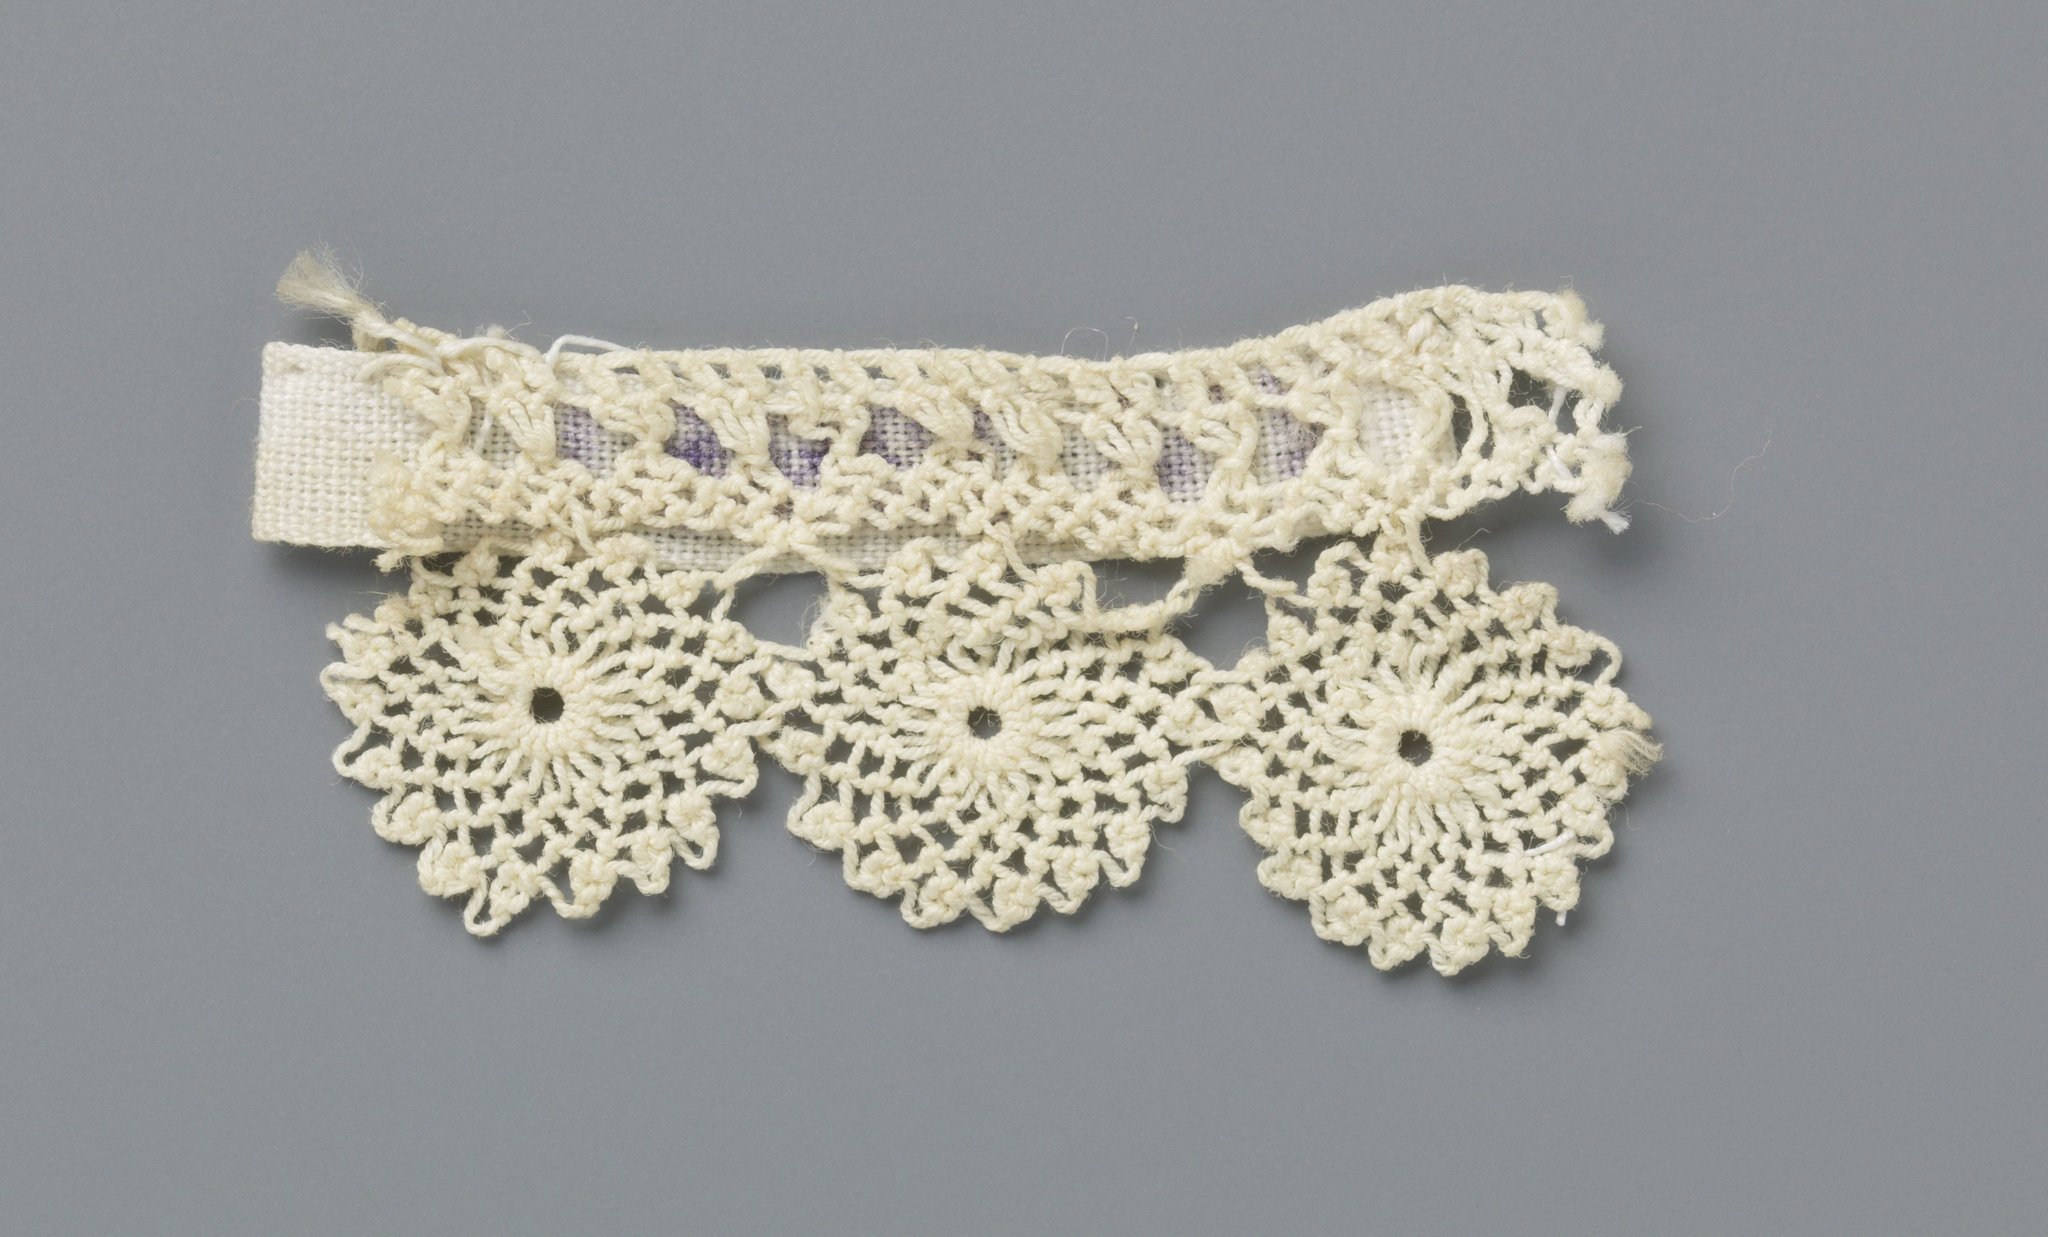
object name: strip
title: Strook geknoopte kant met drie cirkeltjes onder een smalle rechte baan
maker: Anonymous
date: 1900-1922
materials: linen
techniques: lace, knotted lace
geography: palestine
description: Strook naturelkleurige geknoopte kant: Chebka. Drie cirkeltjes onder een smalle rechte baan.